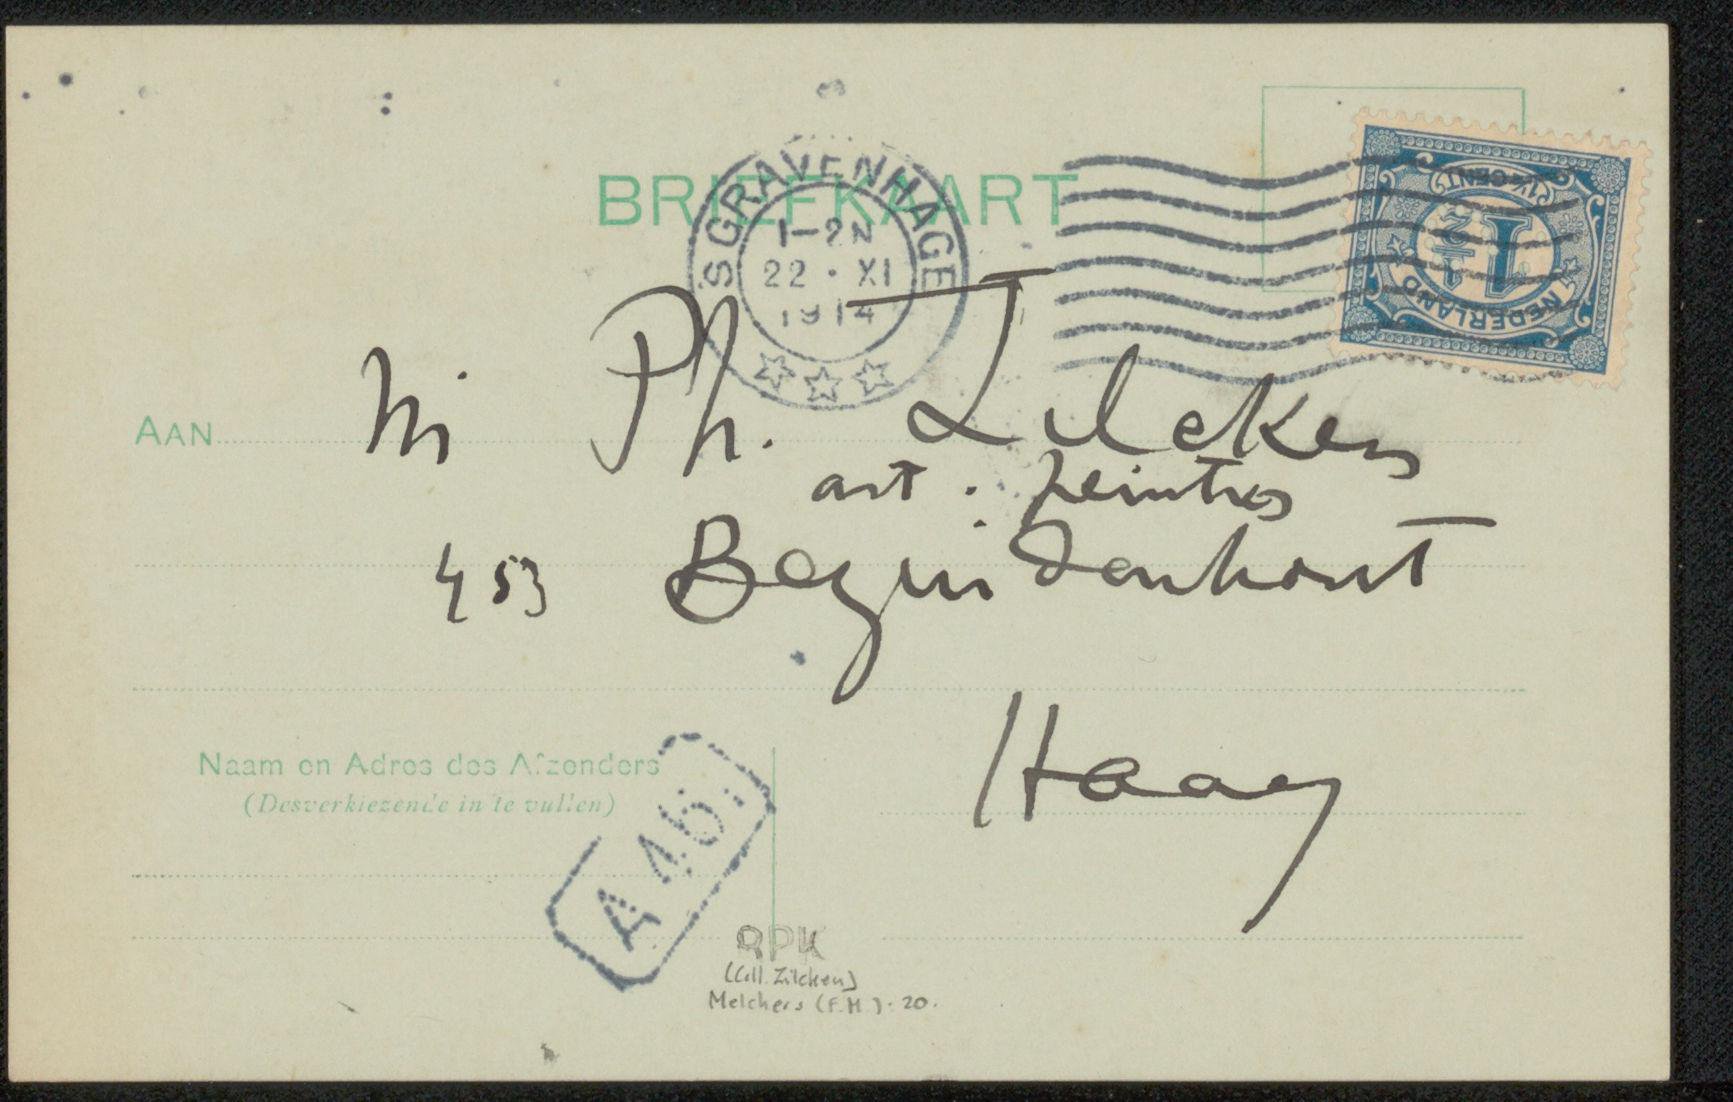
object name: postcard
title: Briefkaart aan Philip Zilcken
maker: franz melchers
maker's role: draughtsman, painter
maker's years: 1868-1944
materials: cardboard, ink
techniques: pen, writing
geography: the hague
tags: the hague, philip zilcken, anonymous historical person portrayed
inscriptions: collector's mark: ‘RPK’